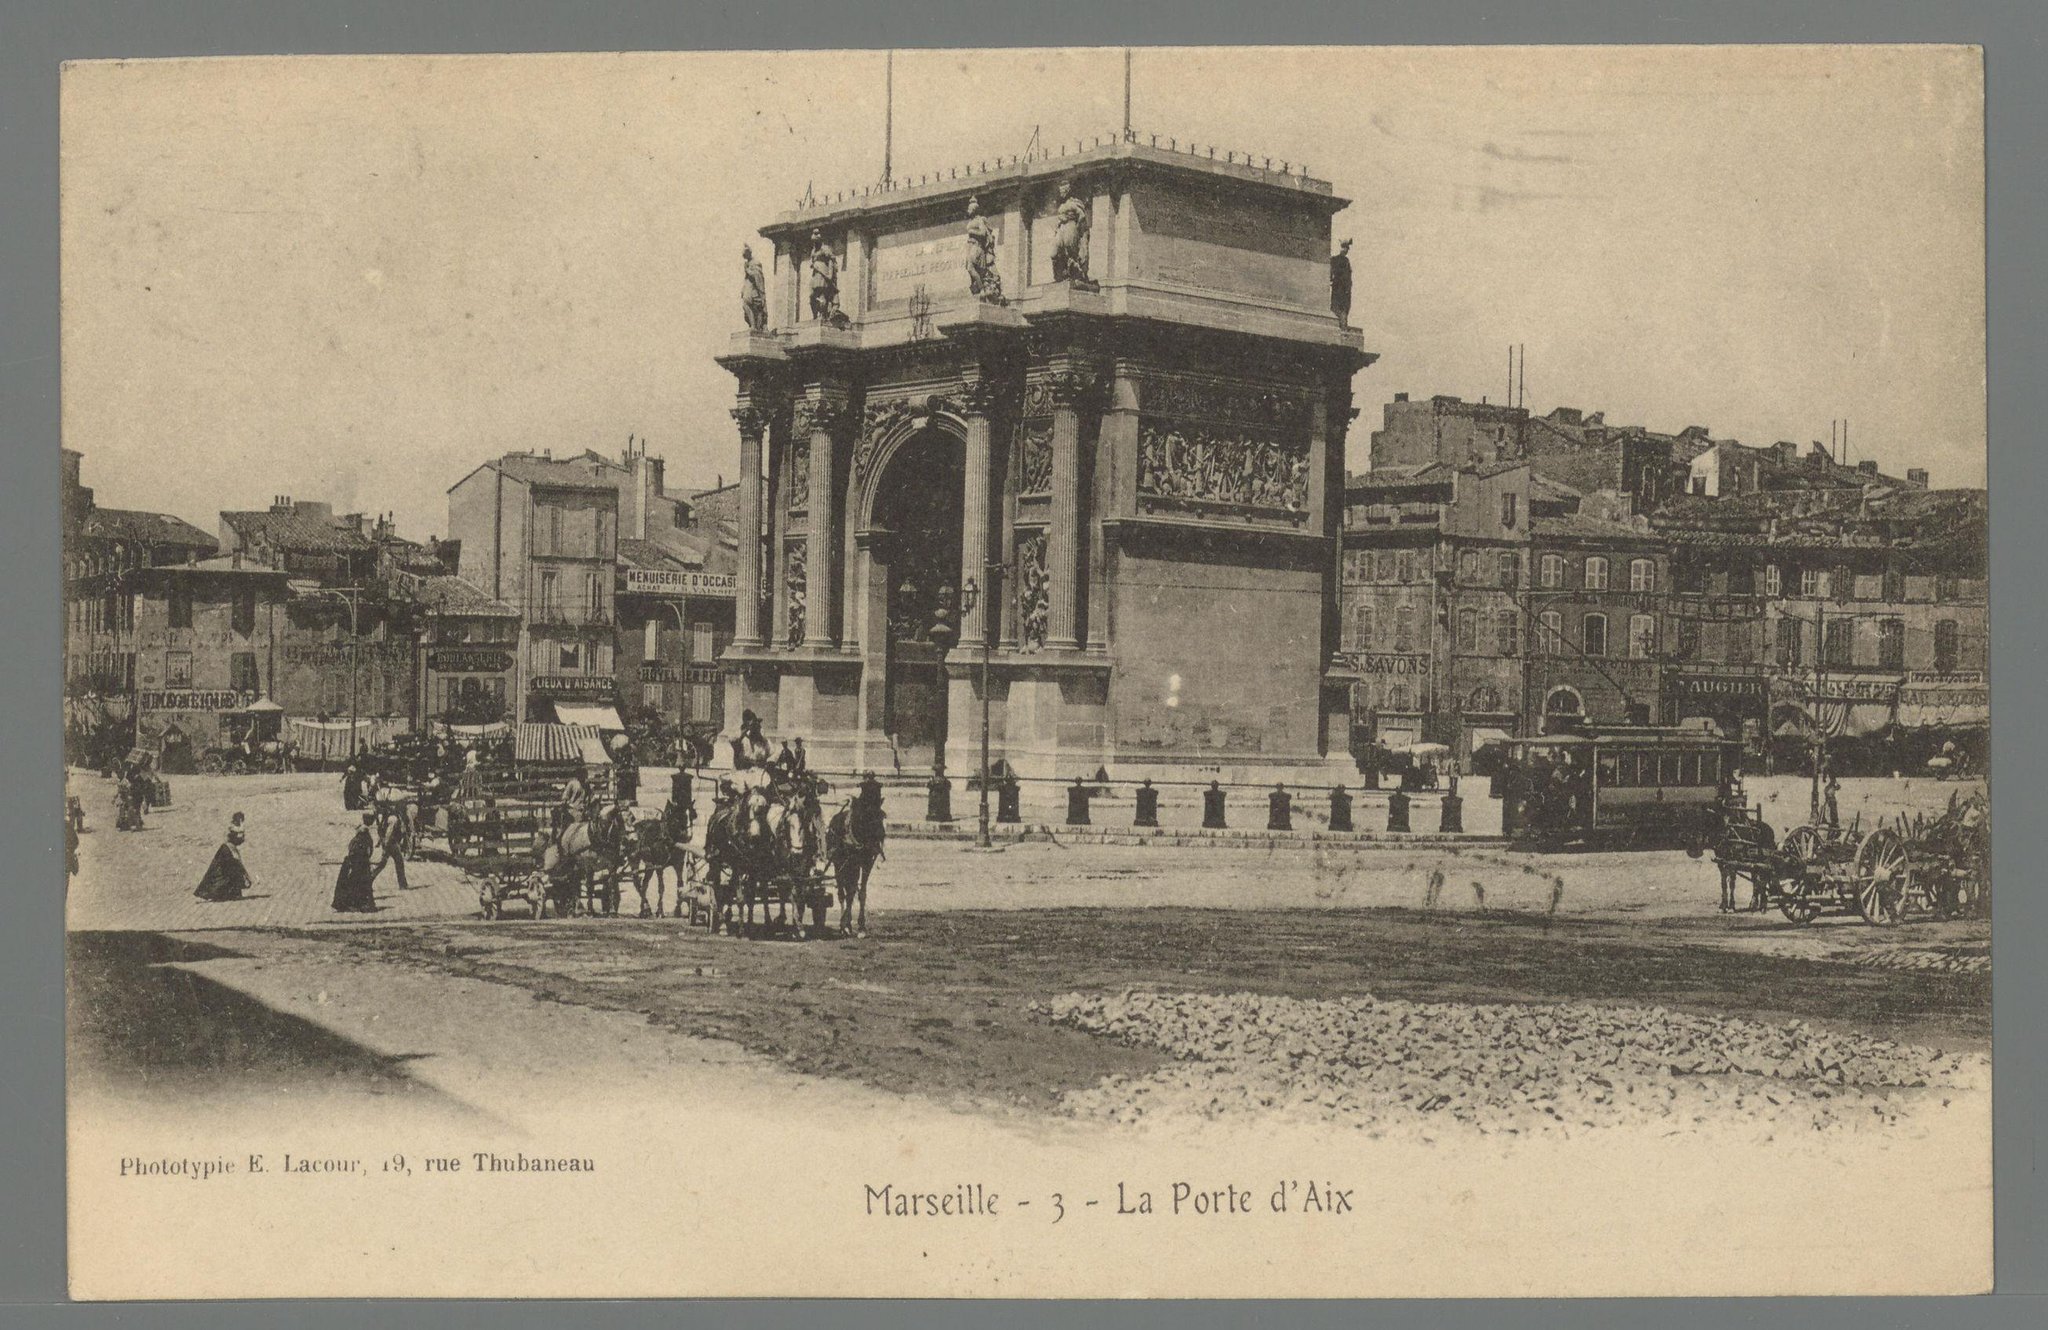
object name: photomechanical print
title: Marseille (...). La Porte d'Aix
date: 1900-1903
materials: cardboard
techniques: photograph, writing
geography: marseille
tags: triumphal arch, square, place, circus, etc. (+ city(-scape) with figures, staffage)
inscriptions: poststempel, verso, gestempeld